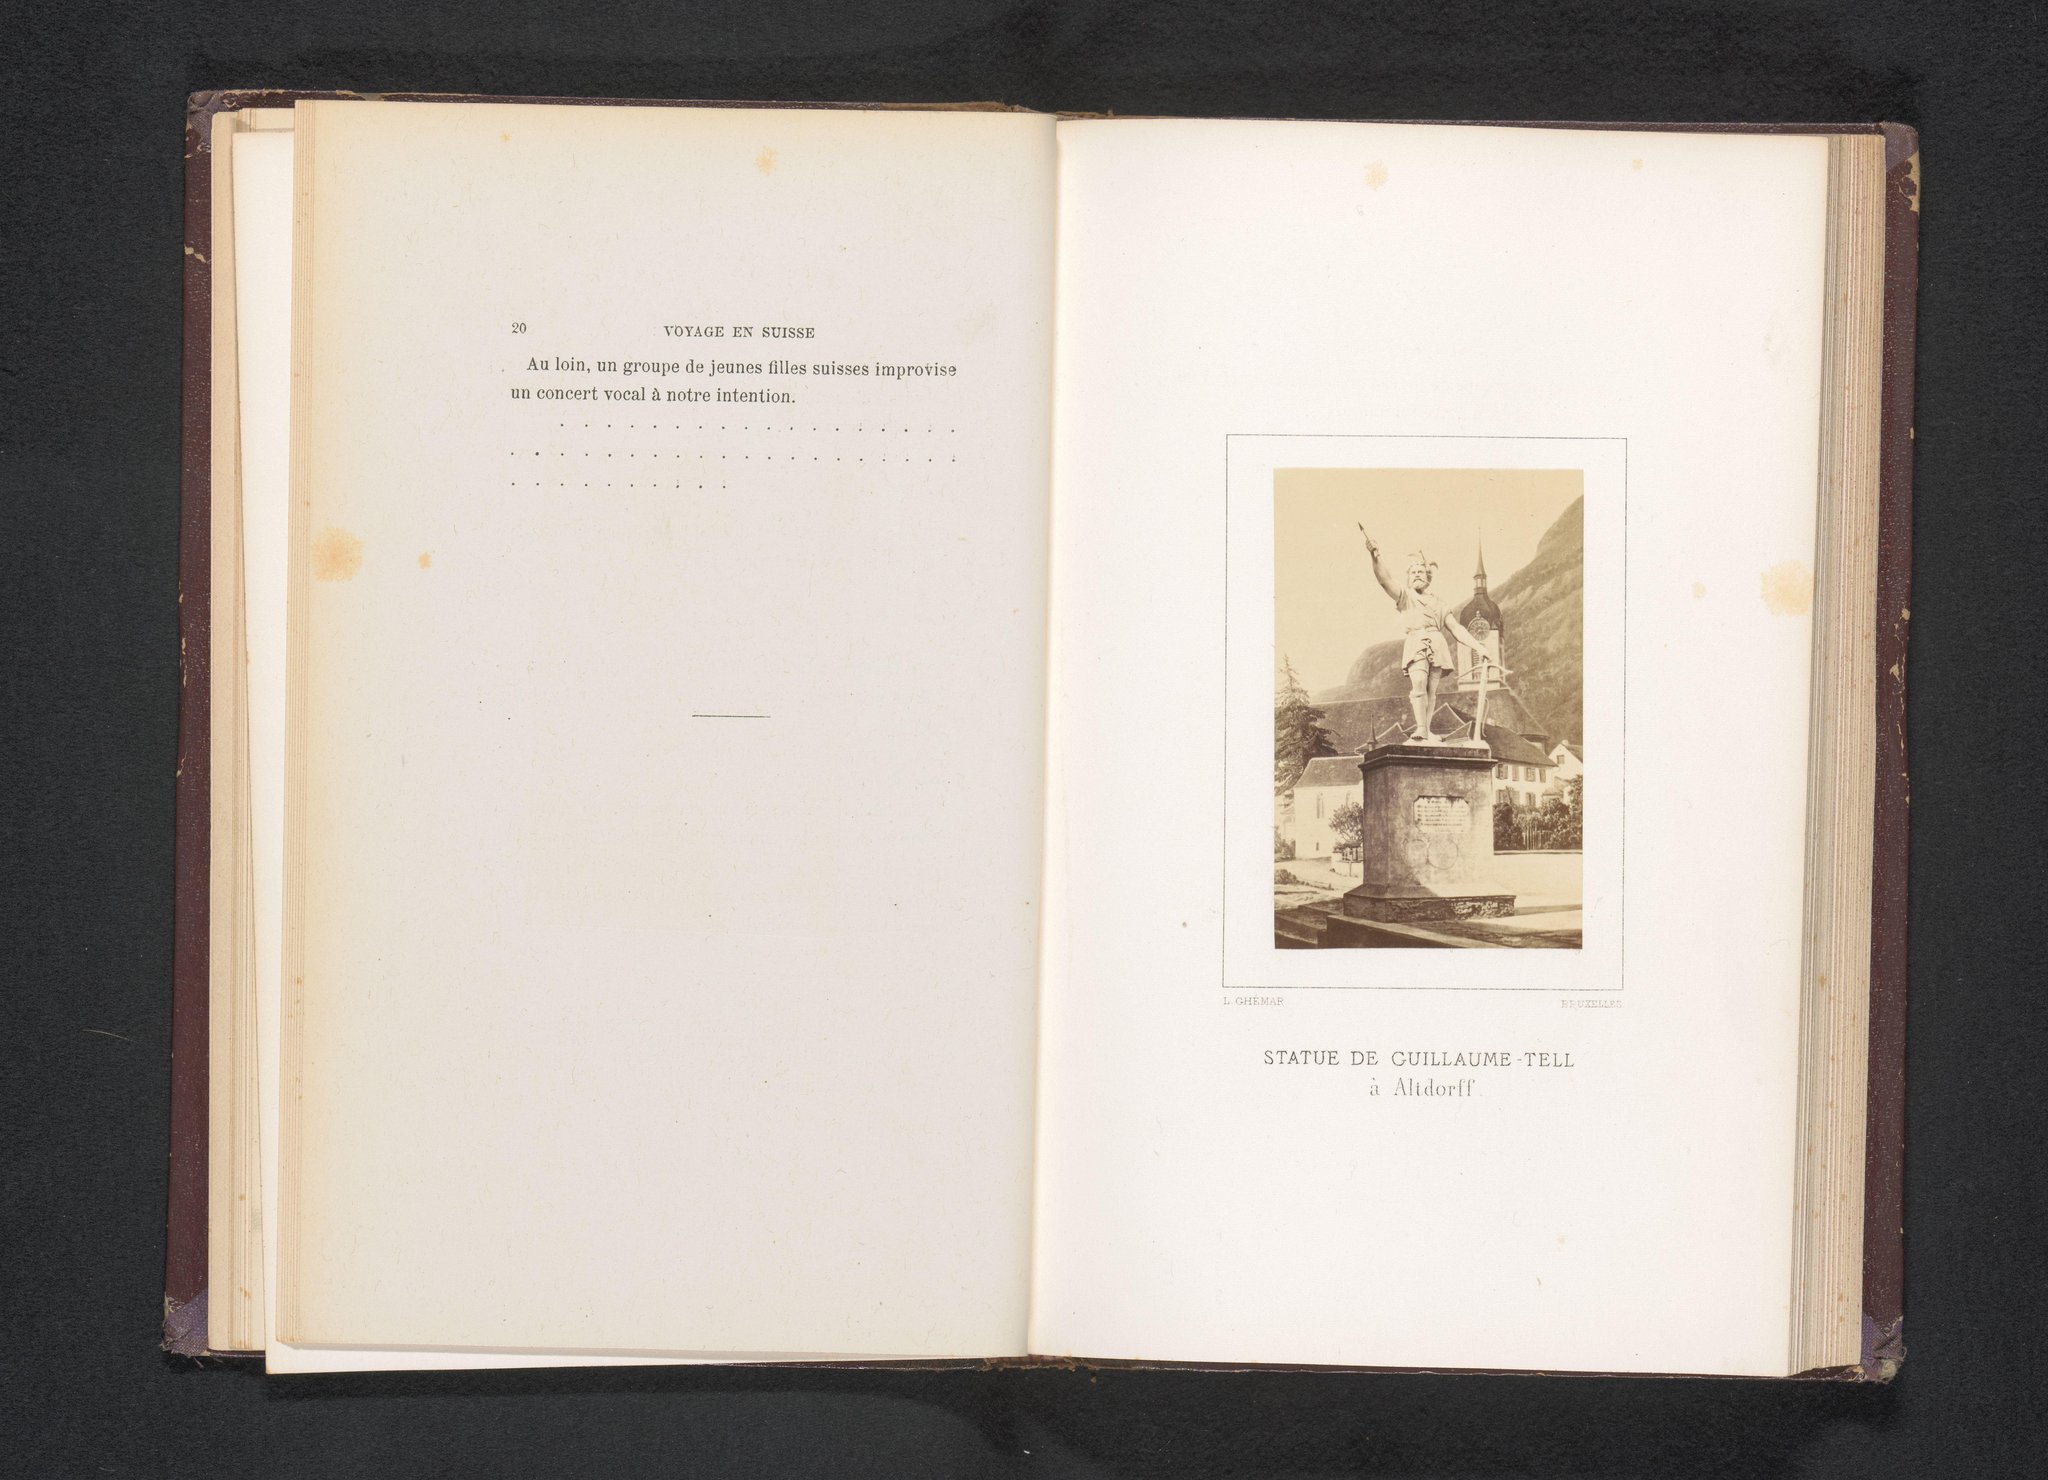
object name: photograph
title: Standbeeld van Guillaume Tell te Altdorf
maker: louis ghémar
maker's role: draughtsman, print maker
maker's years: 1819-1873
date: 1863-1868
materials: photographic support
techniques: albumen print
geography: altdorf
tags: monument, statue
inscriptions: inscription: ‘Bruxelles’